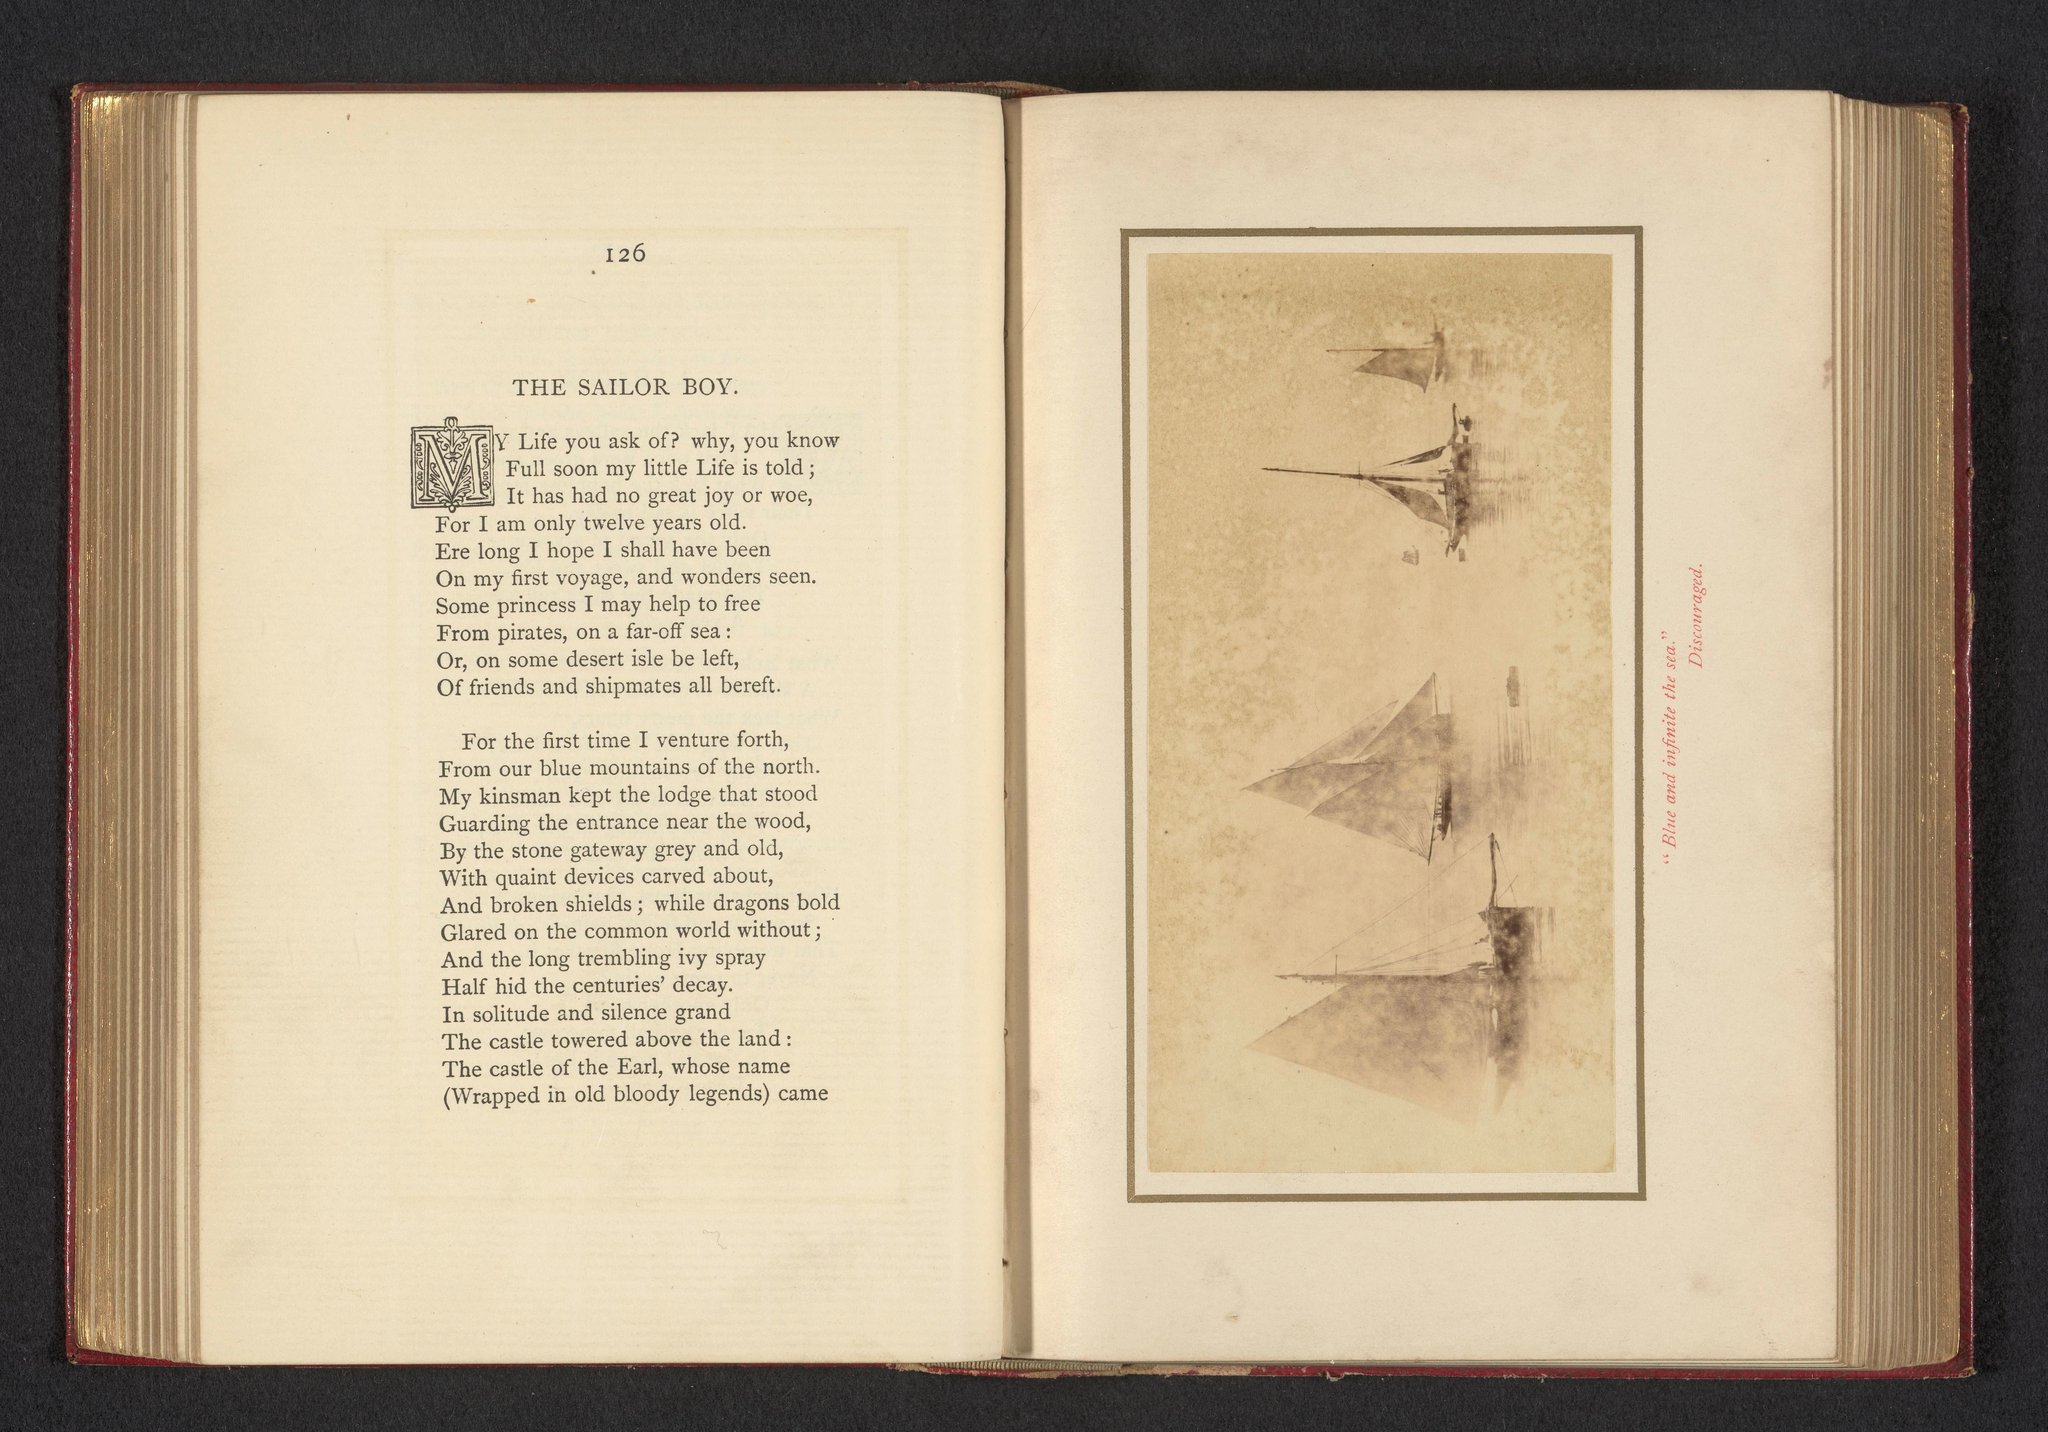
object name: page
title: Zeilboten op het water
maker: john payne jennings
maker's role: fotograaf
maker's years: 1843-1926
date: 1872-1882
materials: photographic support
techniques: albumen print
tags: sailing-ship, sailing-boat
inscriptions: inscription: ‘“ Blue and infinite the sea.” Discouraged.’